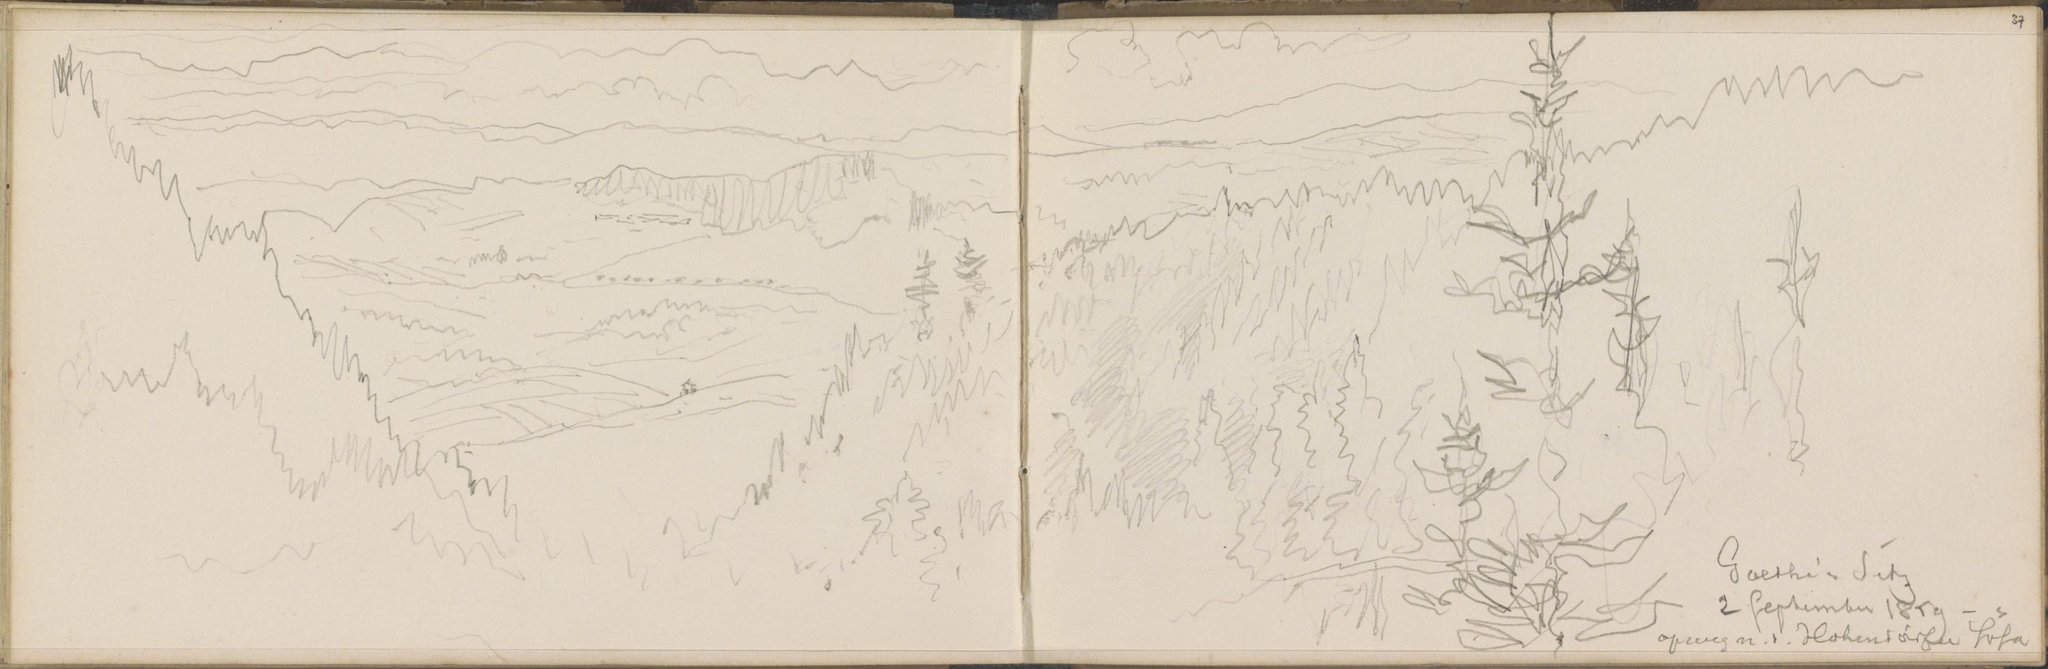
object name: sketchbook leaf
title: Landschap in Bohemen, vermoedelijk één van de plekken die Goethe bezocht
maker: johannes tavenraat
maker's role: draughtsman, painter, print maker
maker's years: 1809-1881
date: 1809-1869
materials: paper, pencil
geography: bohemia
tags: mountains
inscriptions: date and inscription: ‘Goethe's [..]/ 2 september 1869-/ op weg n [...] Hohens[...]’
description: Blad 36 verso en 37 recto uit een schetsboek met 48 bladen.